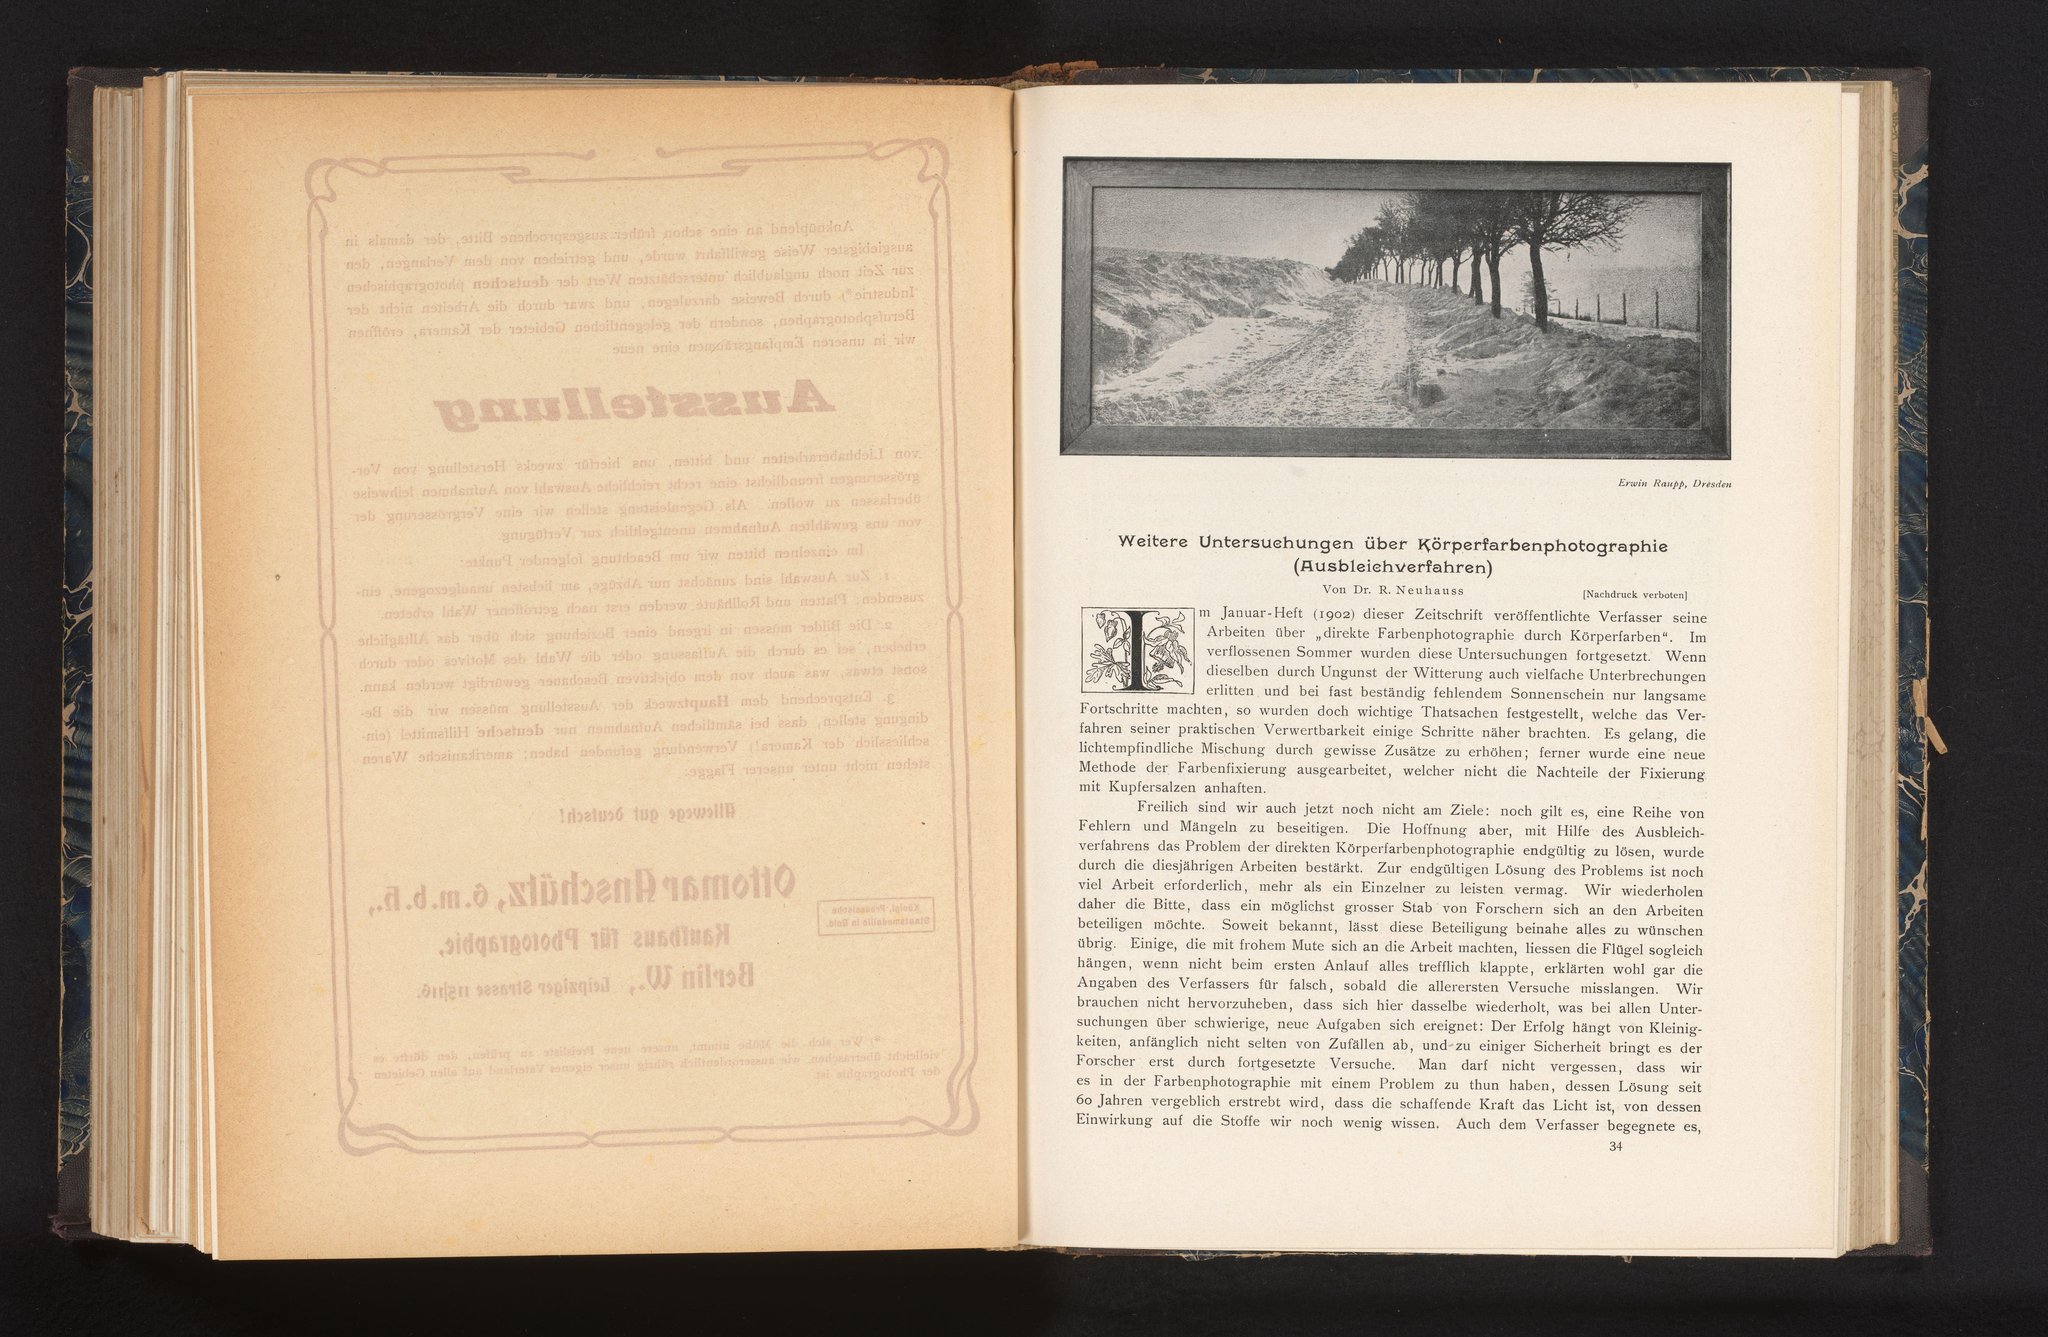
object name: photomechanical print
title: Gezicht op een pad langs een rij bomen in een lijst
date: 1897-1902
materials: paper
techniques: autotype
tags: trees, road, path, frame of painting, etc.